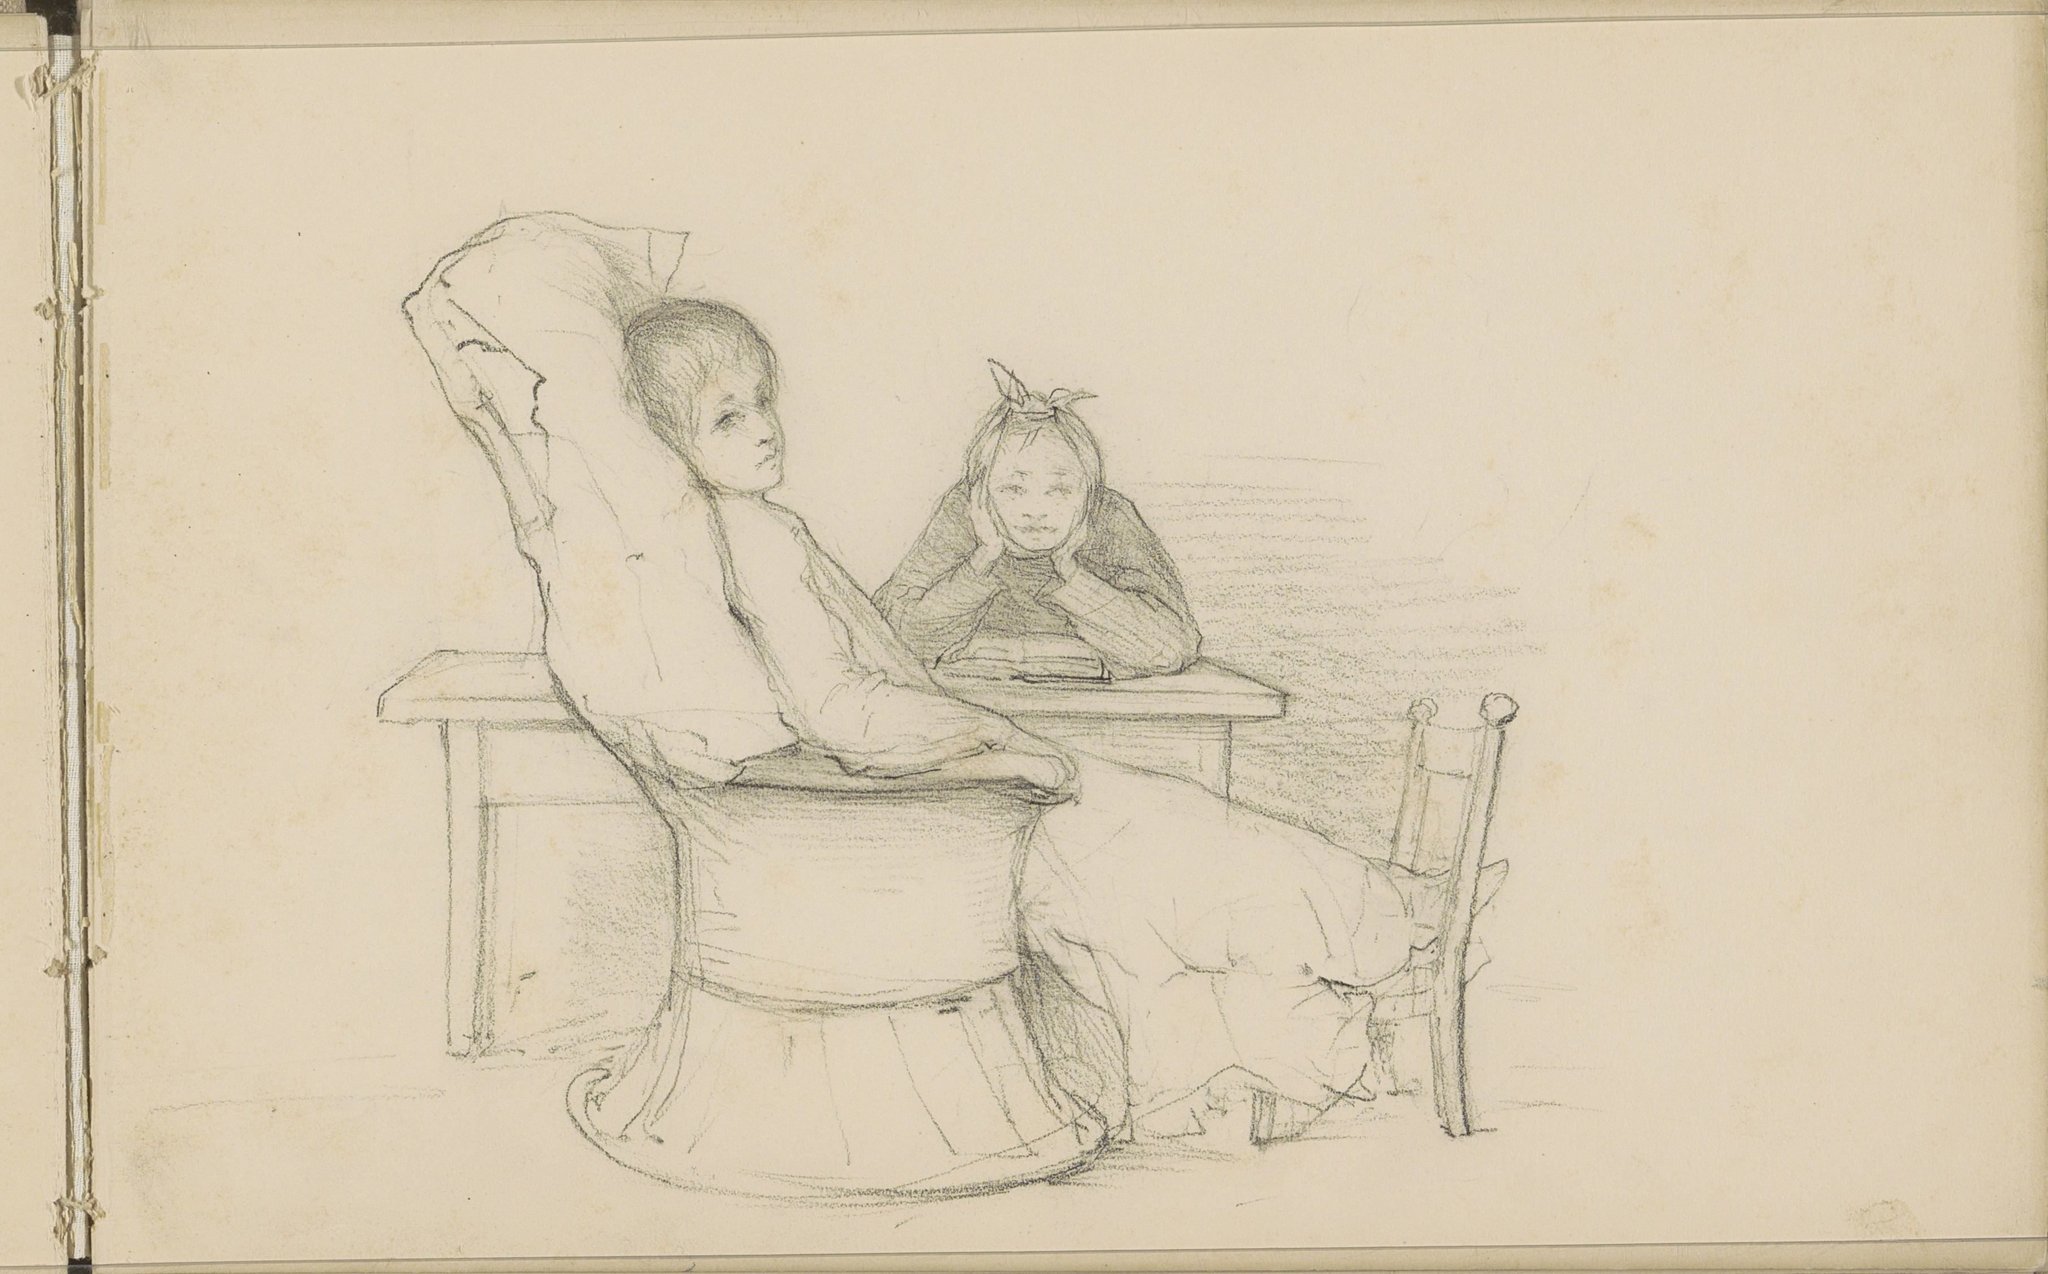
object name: sketchbook leaf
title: Ziek meisje in een stoel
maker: a.a.l. de grammont-hubrecht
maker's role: draughtsman, painter, print maker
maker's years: 1855-1913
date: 1865-1913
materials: chalk, paper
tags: armchair, seat, sitting figure, girl (child between toddler and youth), book - mm - book open, table, patient, sick person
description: Op de achtergrond een tweede meisje, mogelijk een zusje, dat aan een tafel zit met een open boek voor zich en haar hoofd op haar beide handen laat rusten. Blad 7 recto uit een schetsboek met 65 bladen.